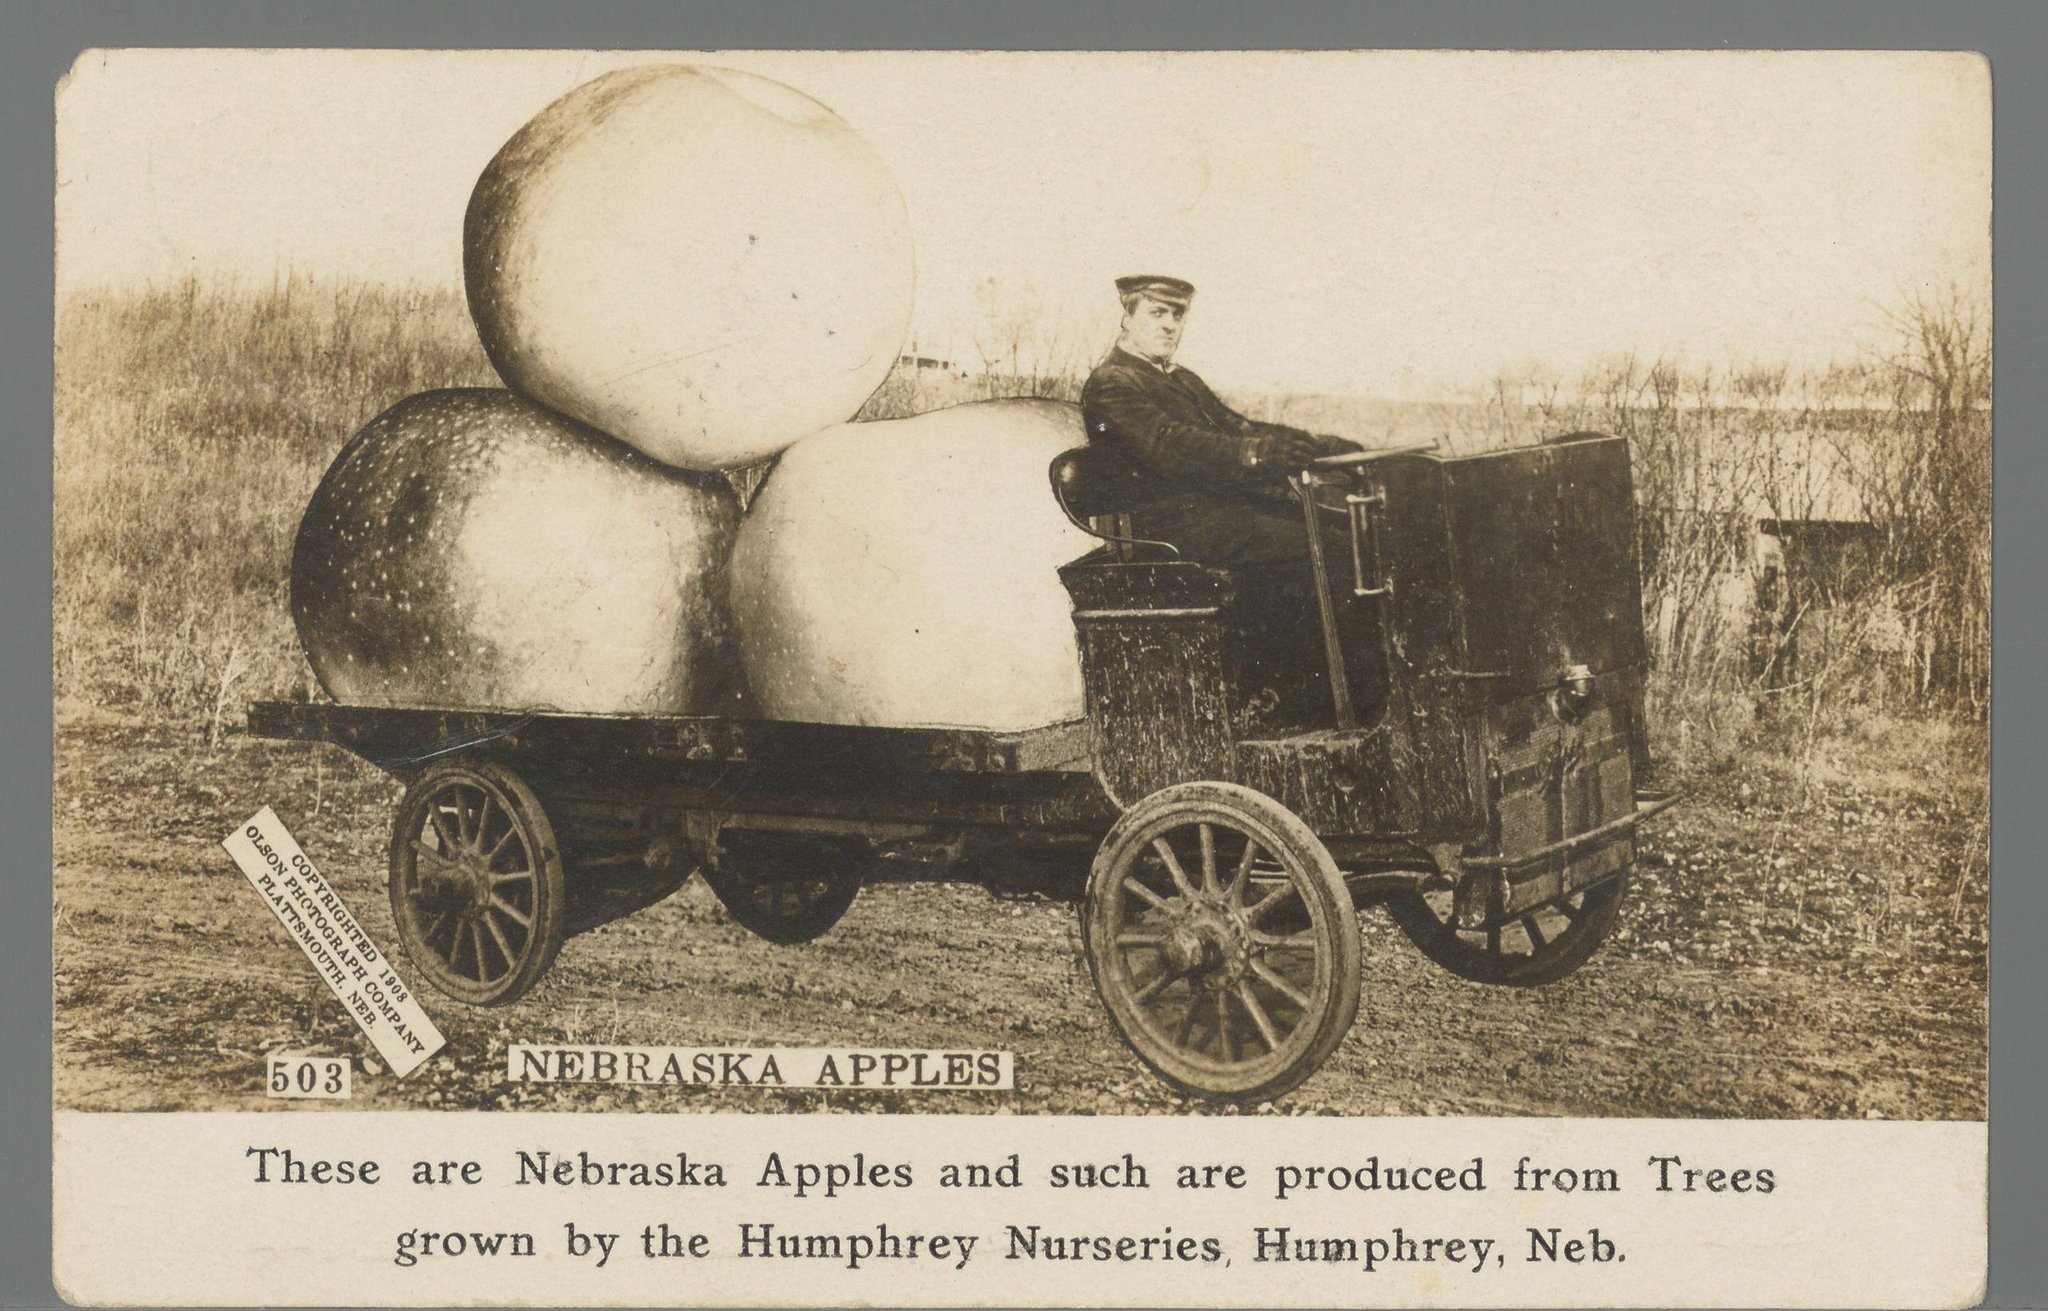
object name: photograph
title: Nebraska Apples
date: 1908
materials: paper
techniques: gelatin silver print, typewriting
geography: plattsmouth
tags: fruits: apple, farmers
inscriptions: poststempel, verso, gestempeld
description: Prentbriefkaart met fotomontage van een vrachtauto met drie reusachtige appels, gekweekt door Humphrey Nurseries, Humphrey, Nebraska.